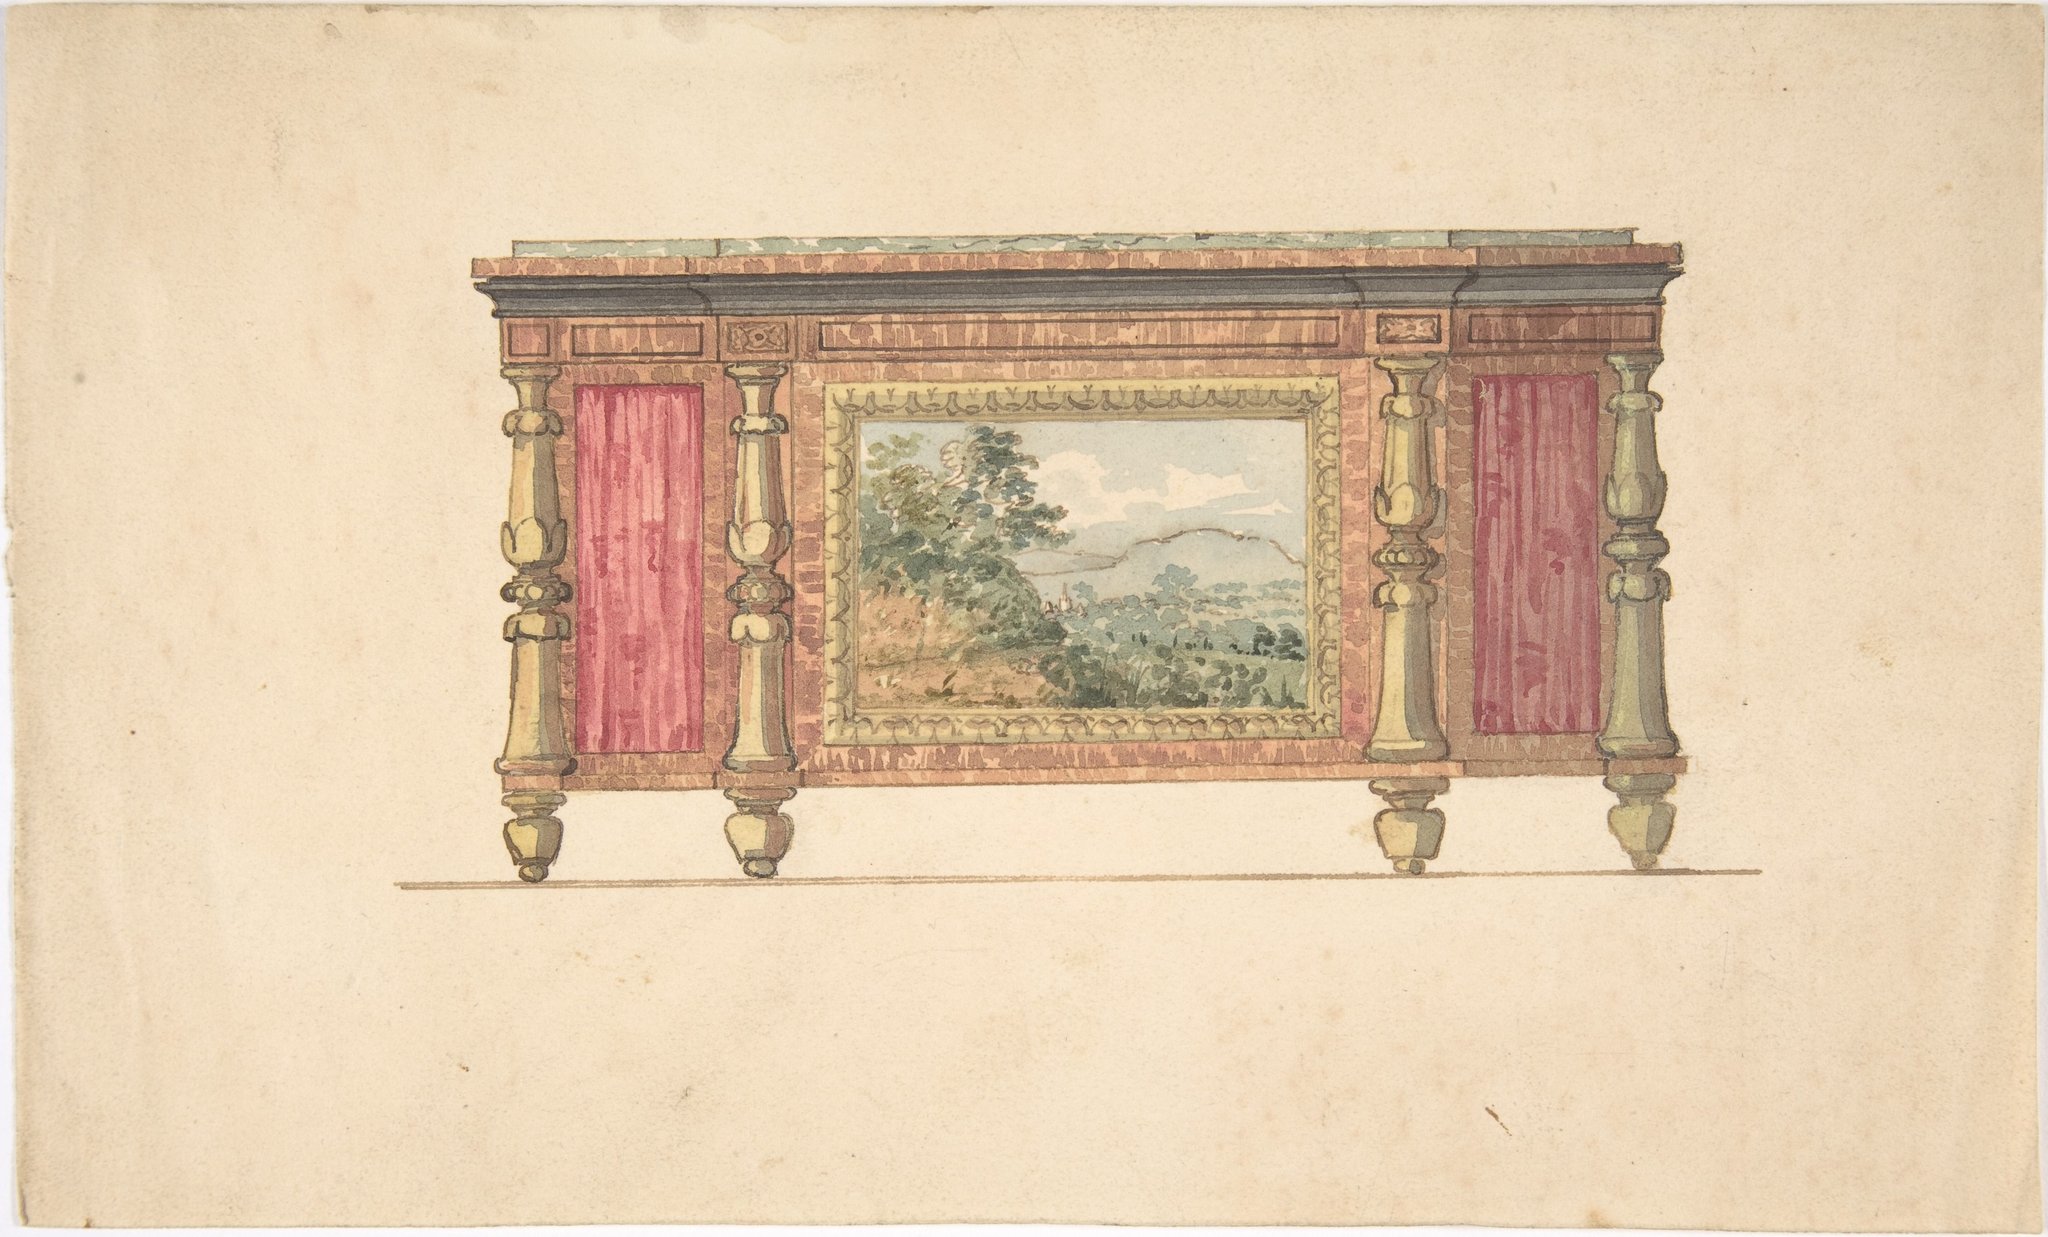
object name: drawing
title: Design for Sideboard with Inset Landscape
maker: anonymous, british, 19th century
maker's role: artist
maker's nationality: british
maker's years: 1800-1900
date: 1801-1833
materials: ink, watercolor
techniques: pen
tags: landscapes,furniture